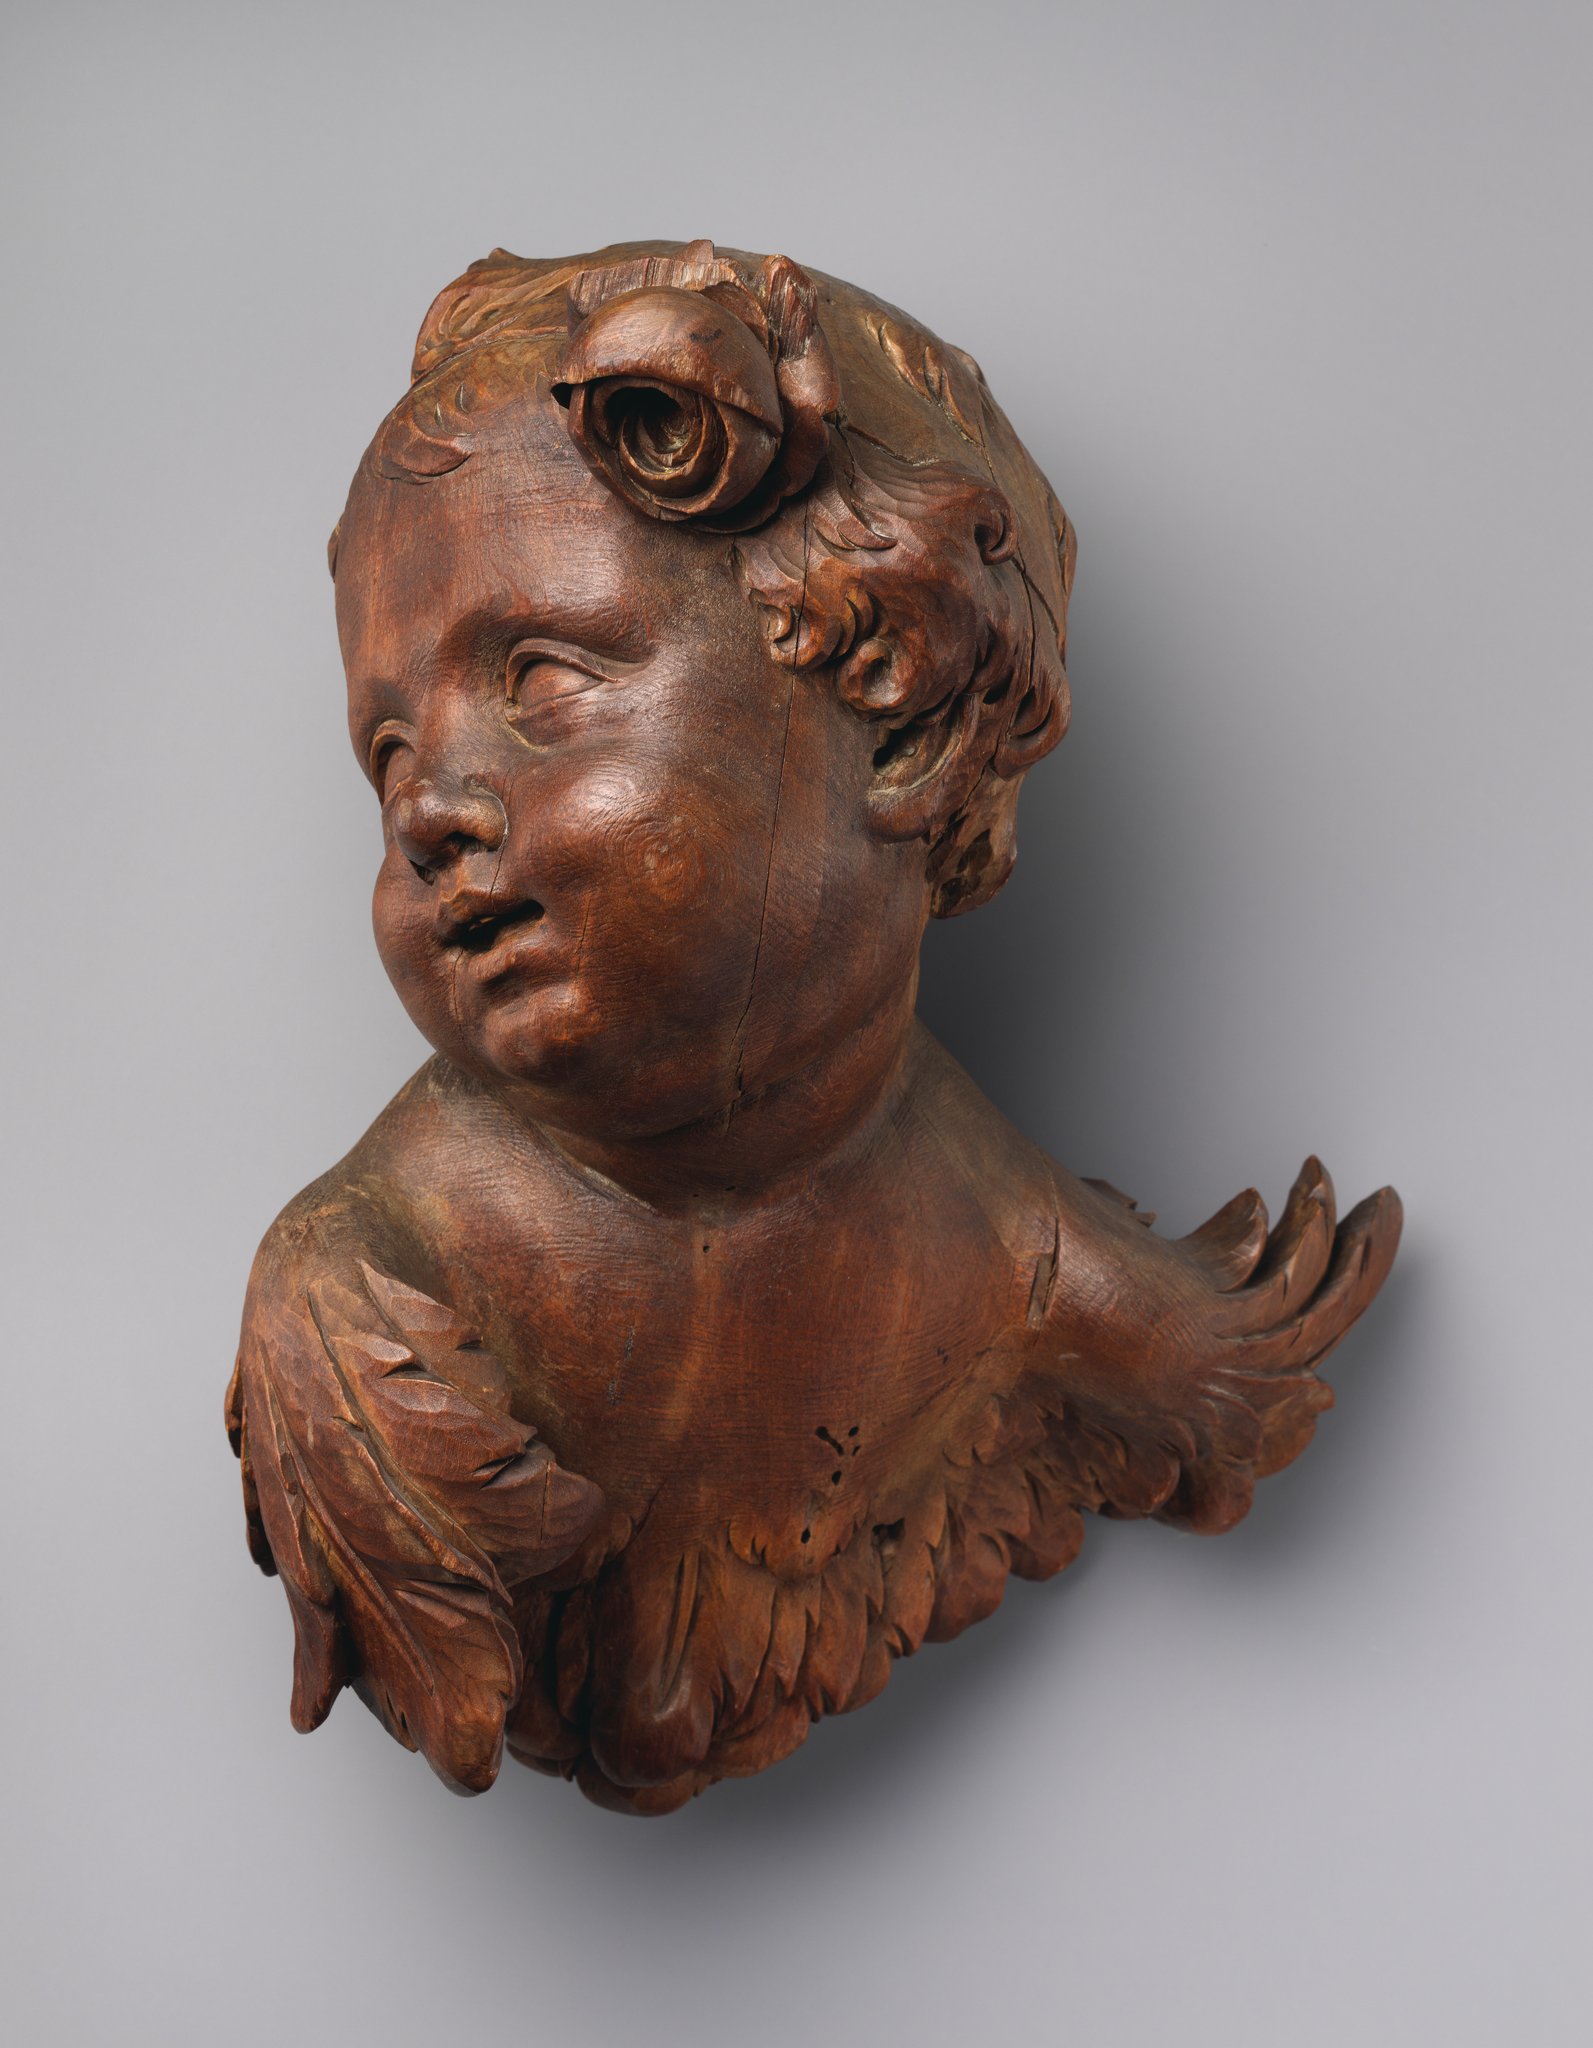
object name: head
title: Angel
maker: ignaz günther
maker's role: artist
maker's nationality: german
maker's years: 1725-1775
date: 1760-1770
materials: gesso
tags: roses,angels